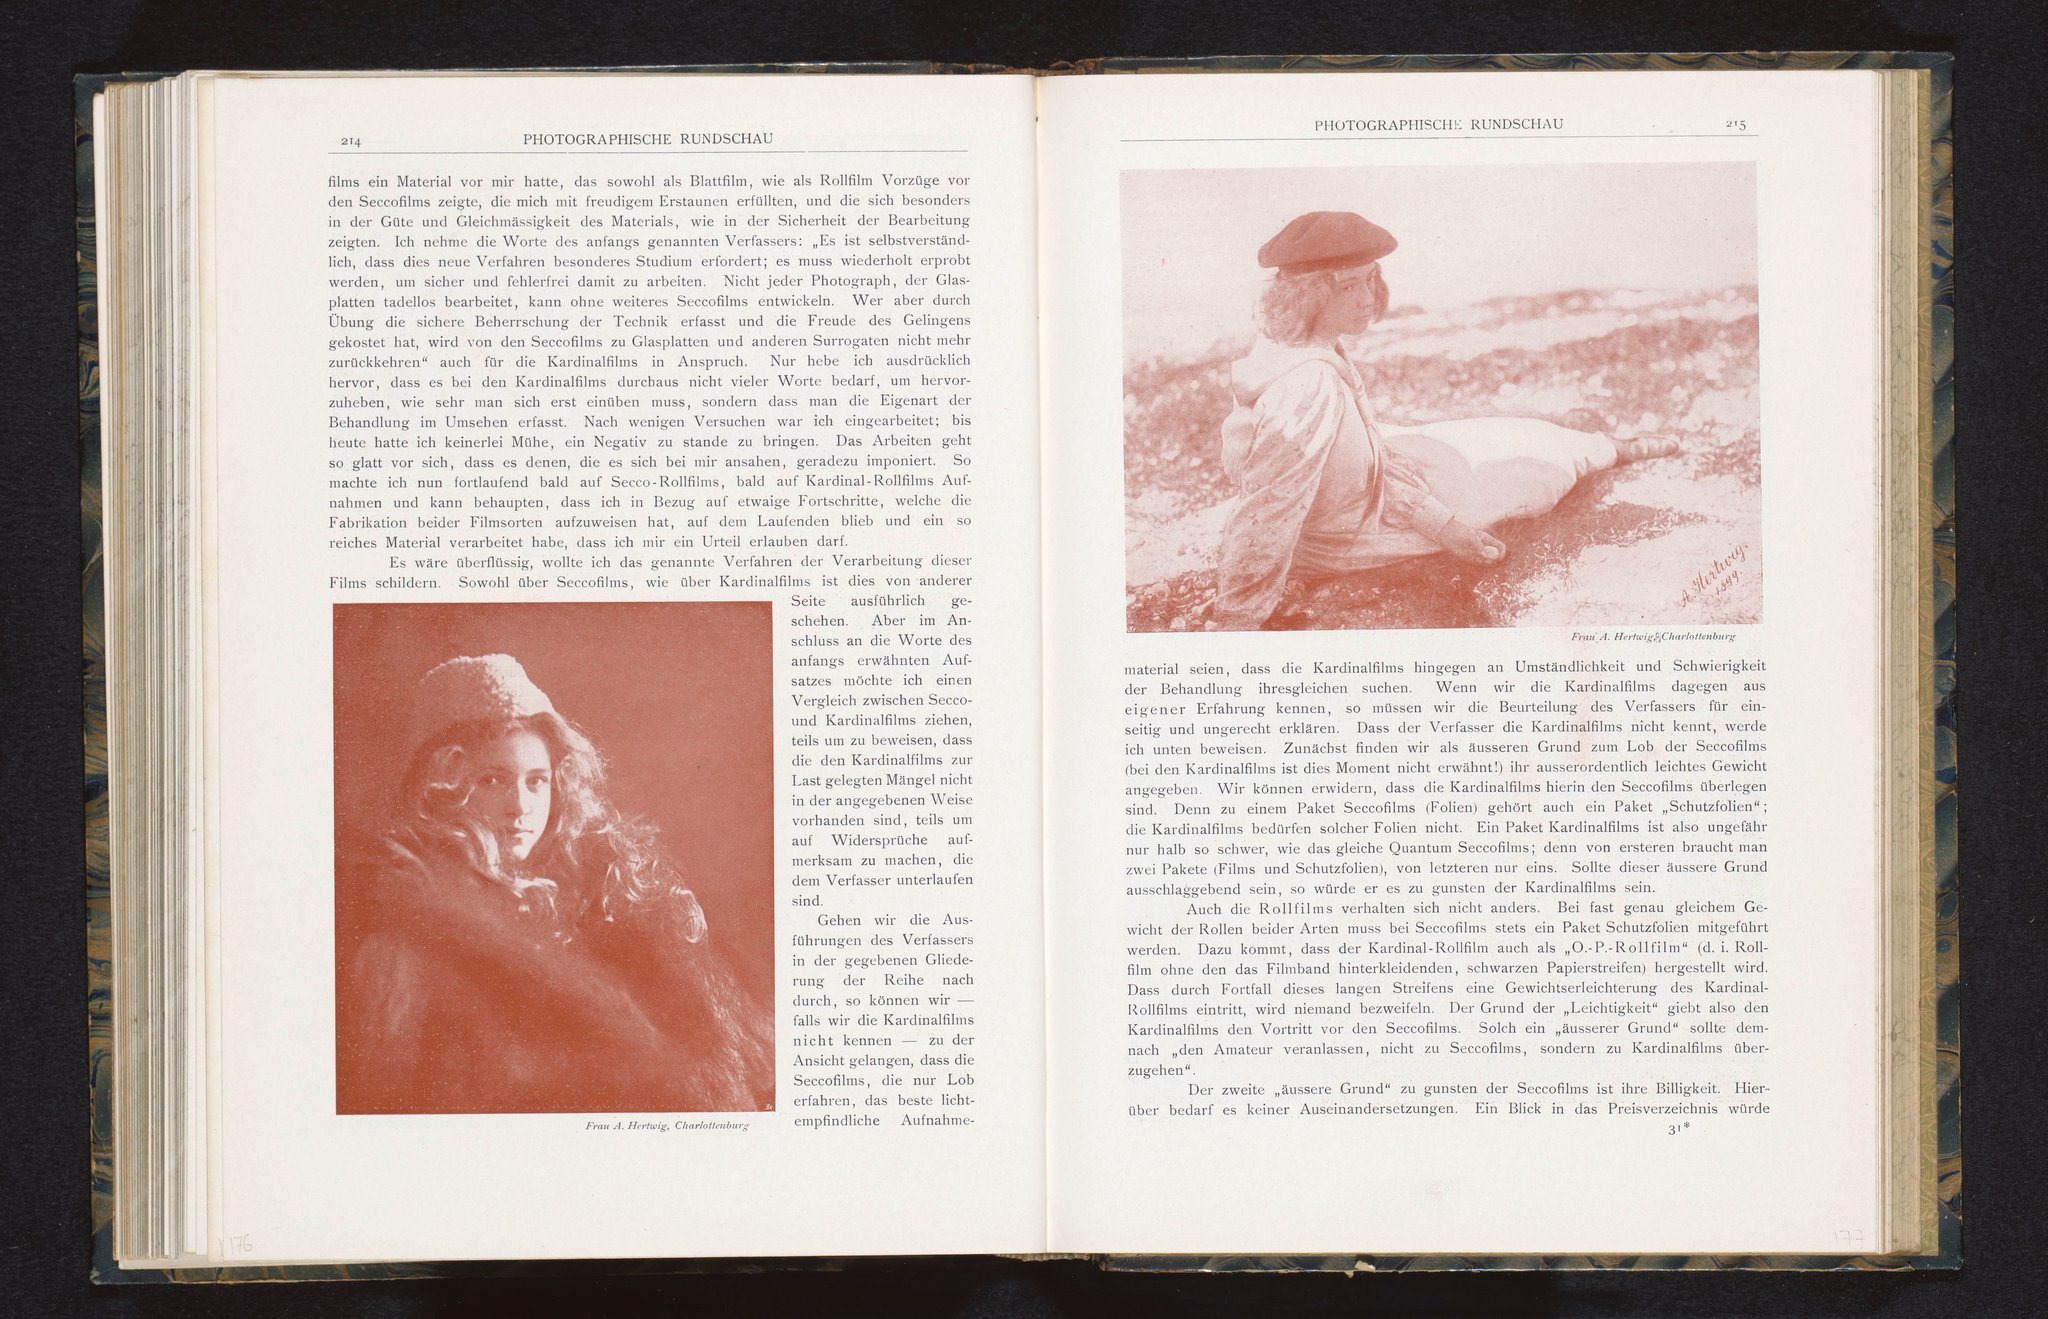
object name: page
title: Portret van een onbekend meisje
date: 1895-1900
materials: paper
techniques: autotype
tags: adolescent, young woman, maiden, anonymous historical person portrayed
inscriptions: monogram: ‘BX’